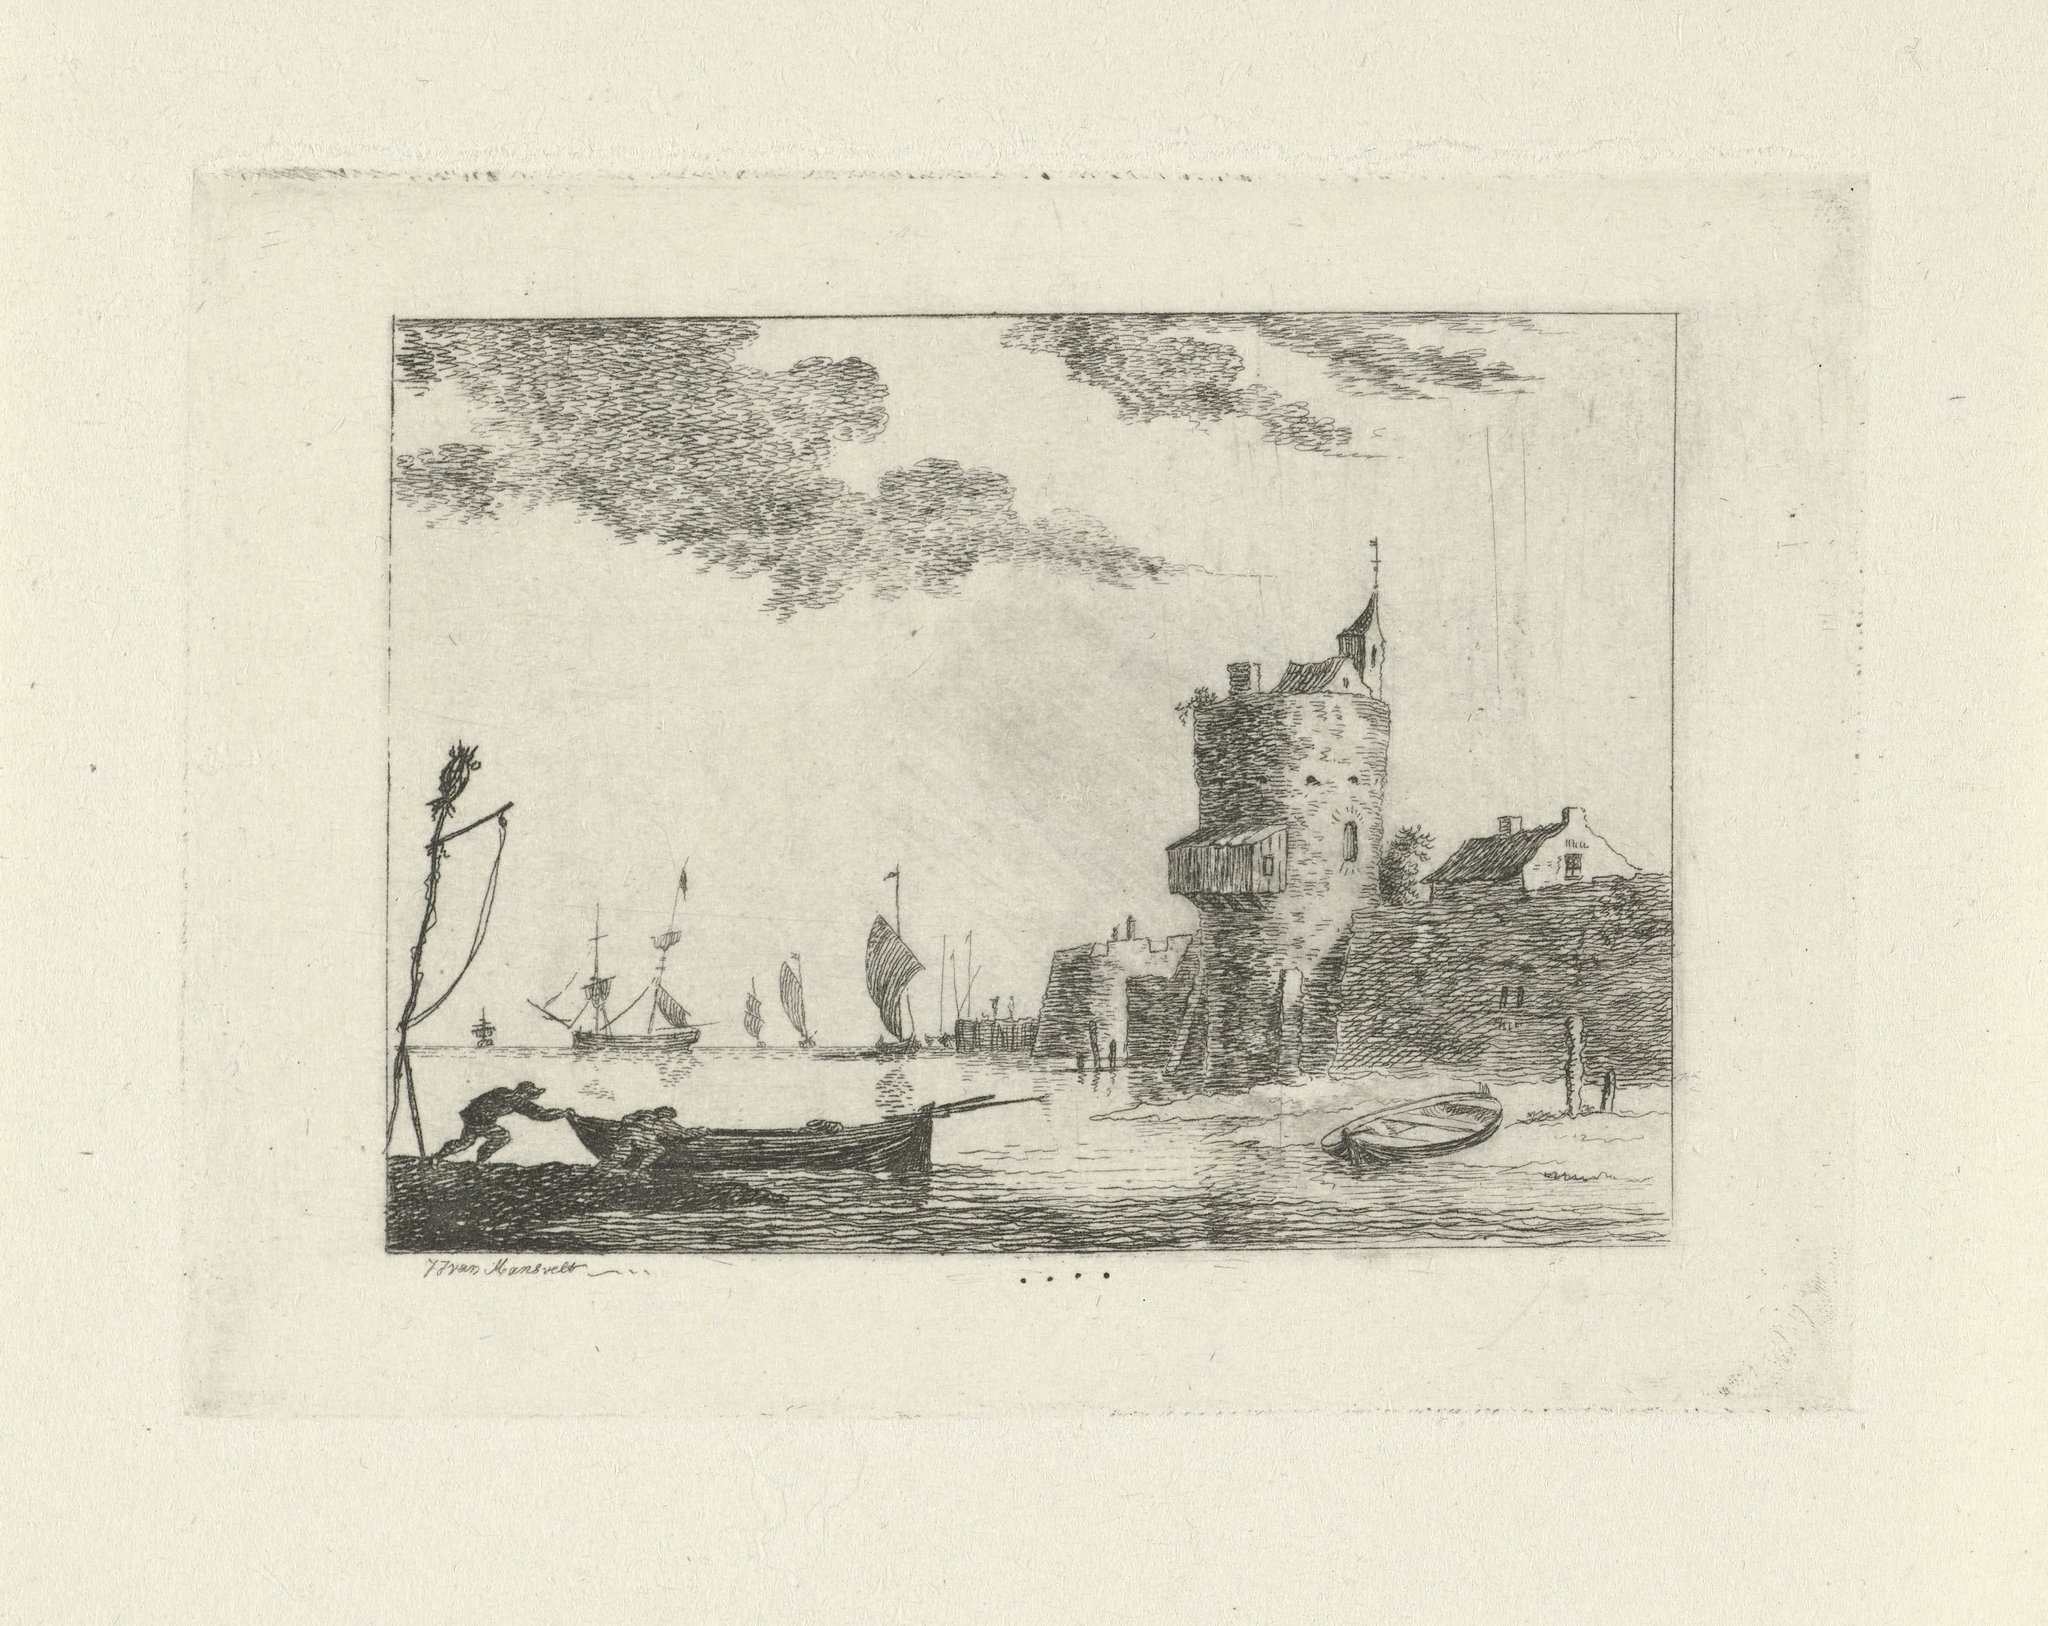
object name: print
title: Boten bij een stadswal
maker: jan izaak van mansvelt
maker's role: print maker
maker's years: 1761-1802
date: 1771-1802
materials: paper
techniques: etching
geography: netherlands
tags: ships (in general), rowing-boat, canoe, etc., city-walls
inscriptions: collector's mark: Lugt 2228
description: Een stadsmuur met een toren aan het water, waarop vele boten. Links op de voorgrond duwen twee mannen hun bootje af.